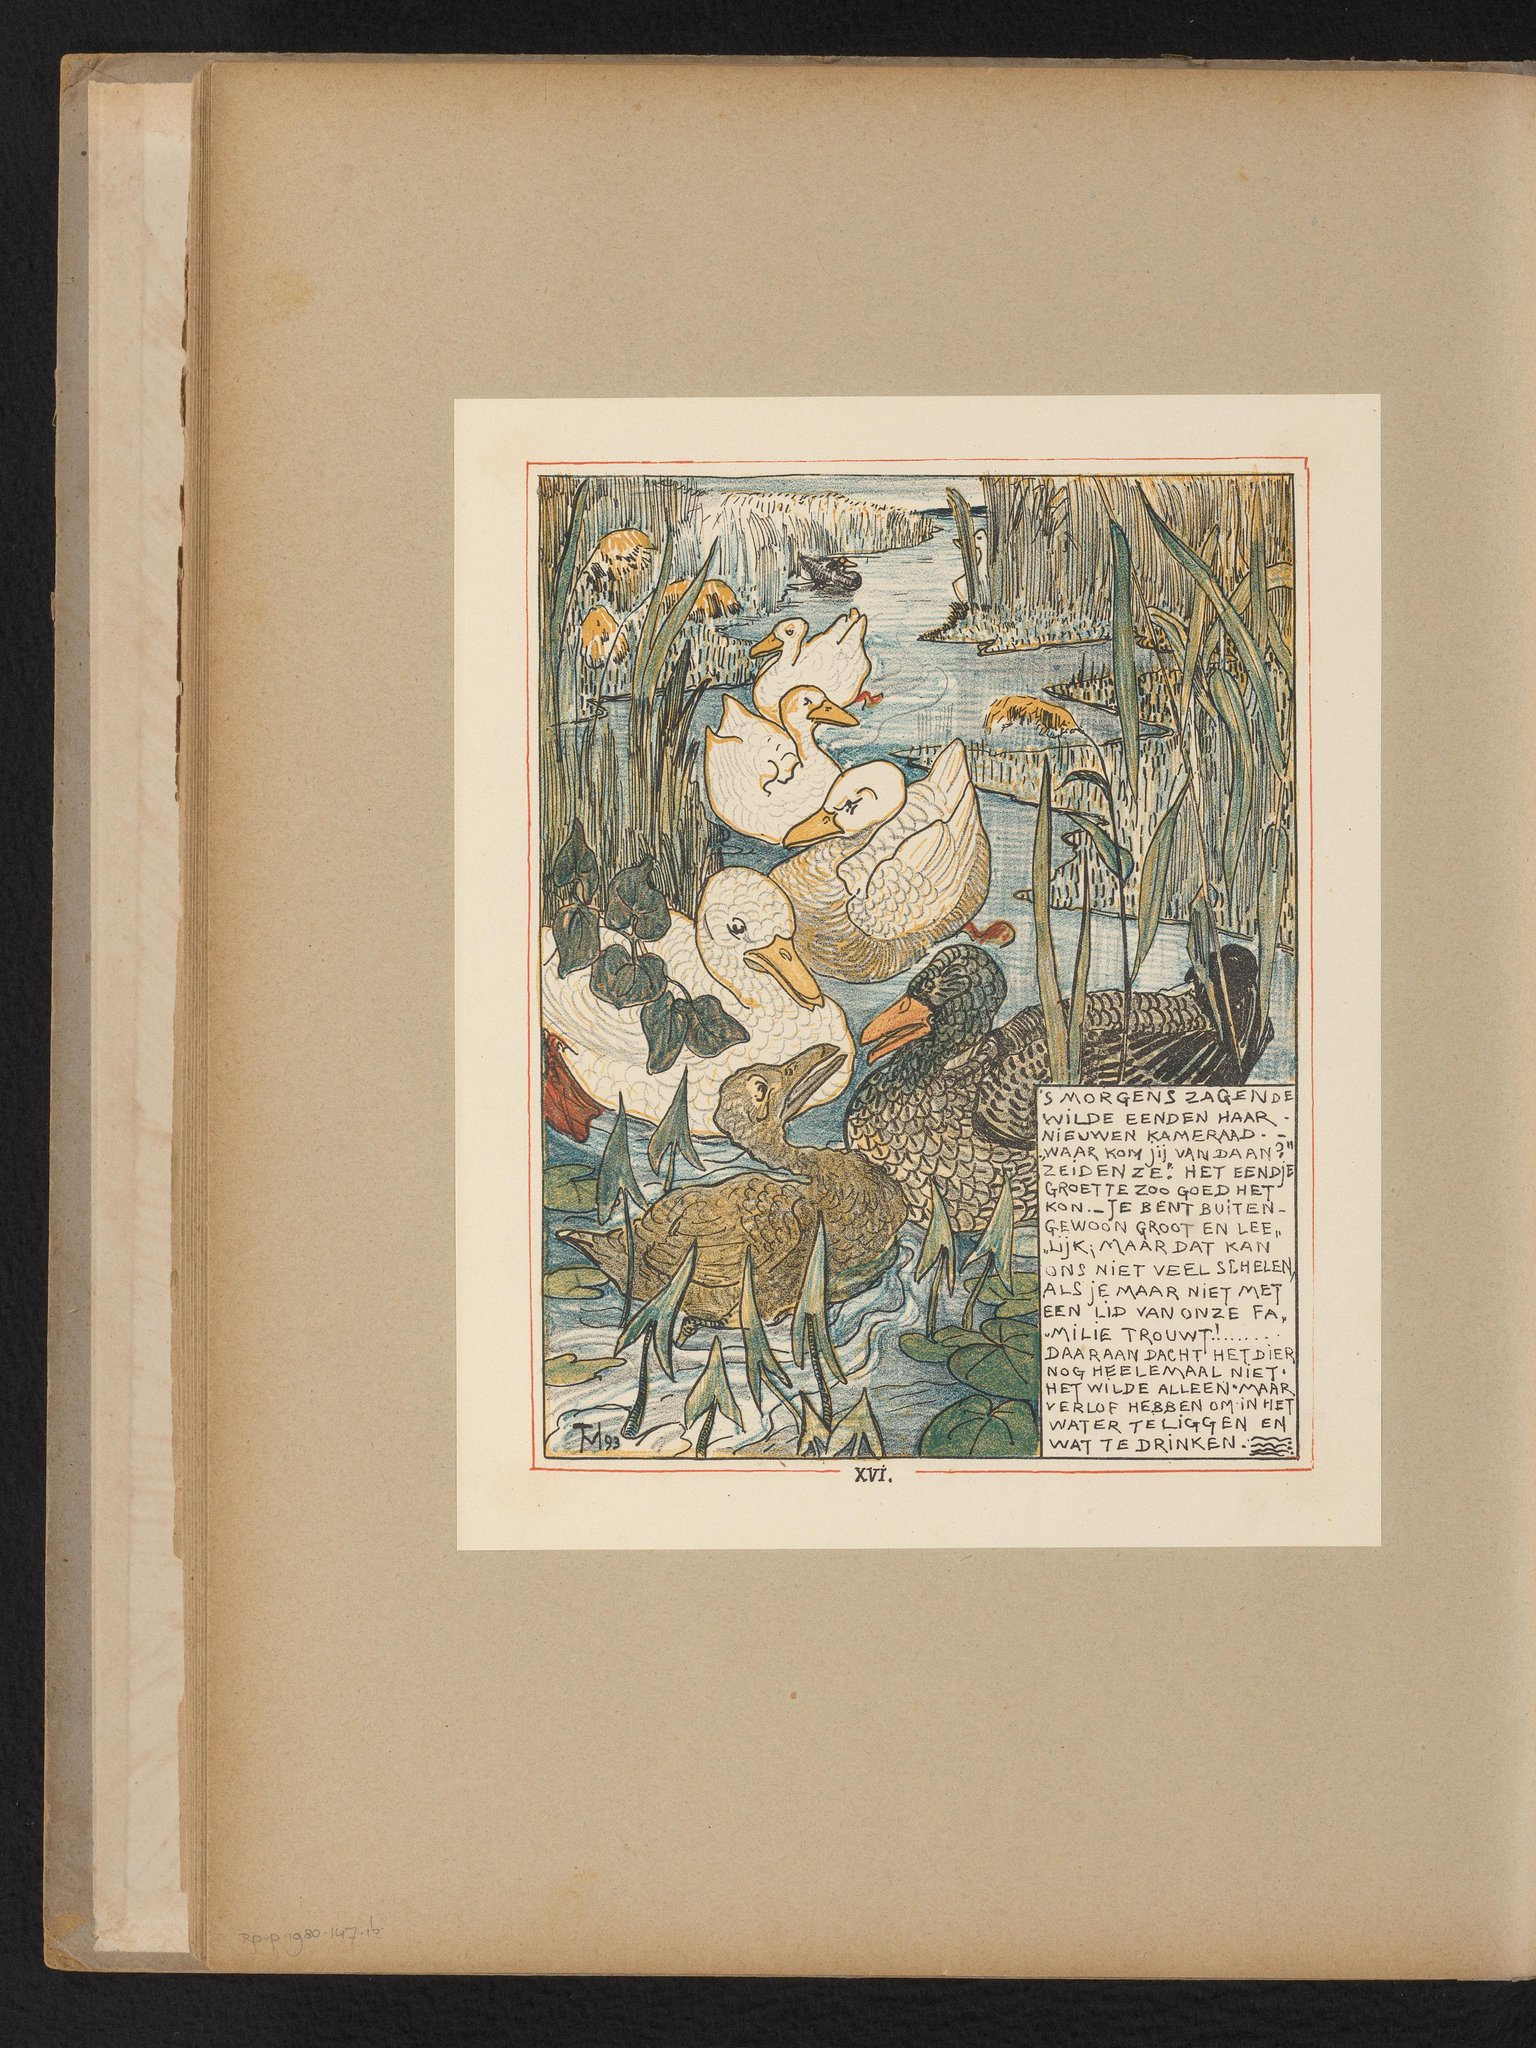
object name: album leaf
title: Het leelijke jonge eendje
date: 1893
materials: paper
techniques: lithograph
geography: the hague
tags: water-birds: duck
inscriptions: date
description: Deze prent maakt deel uit van een album.